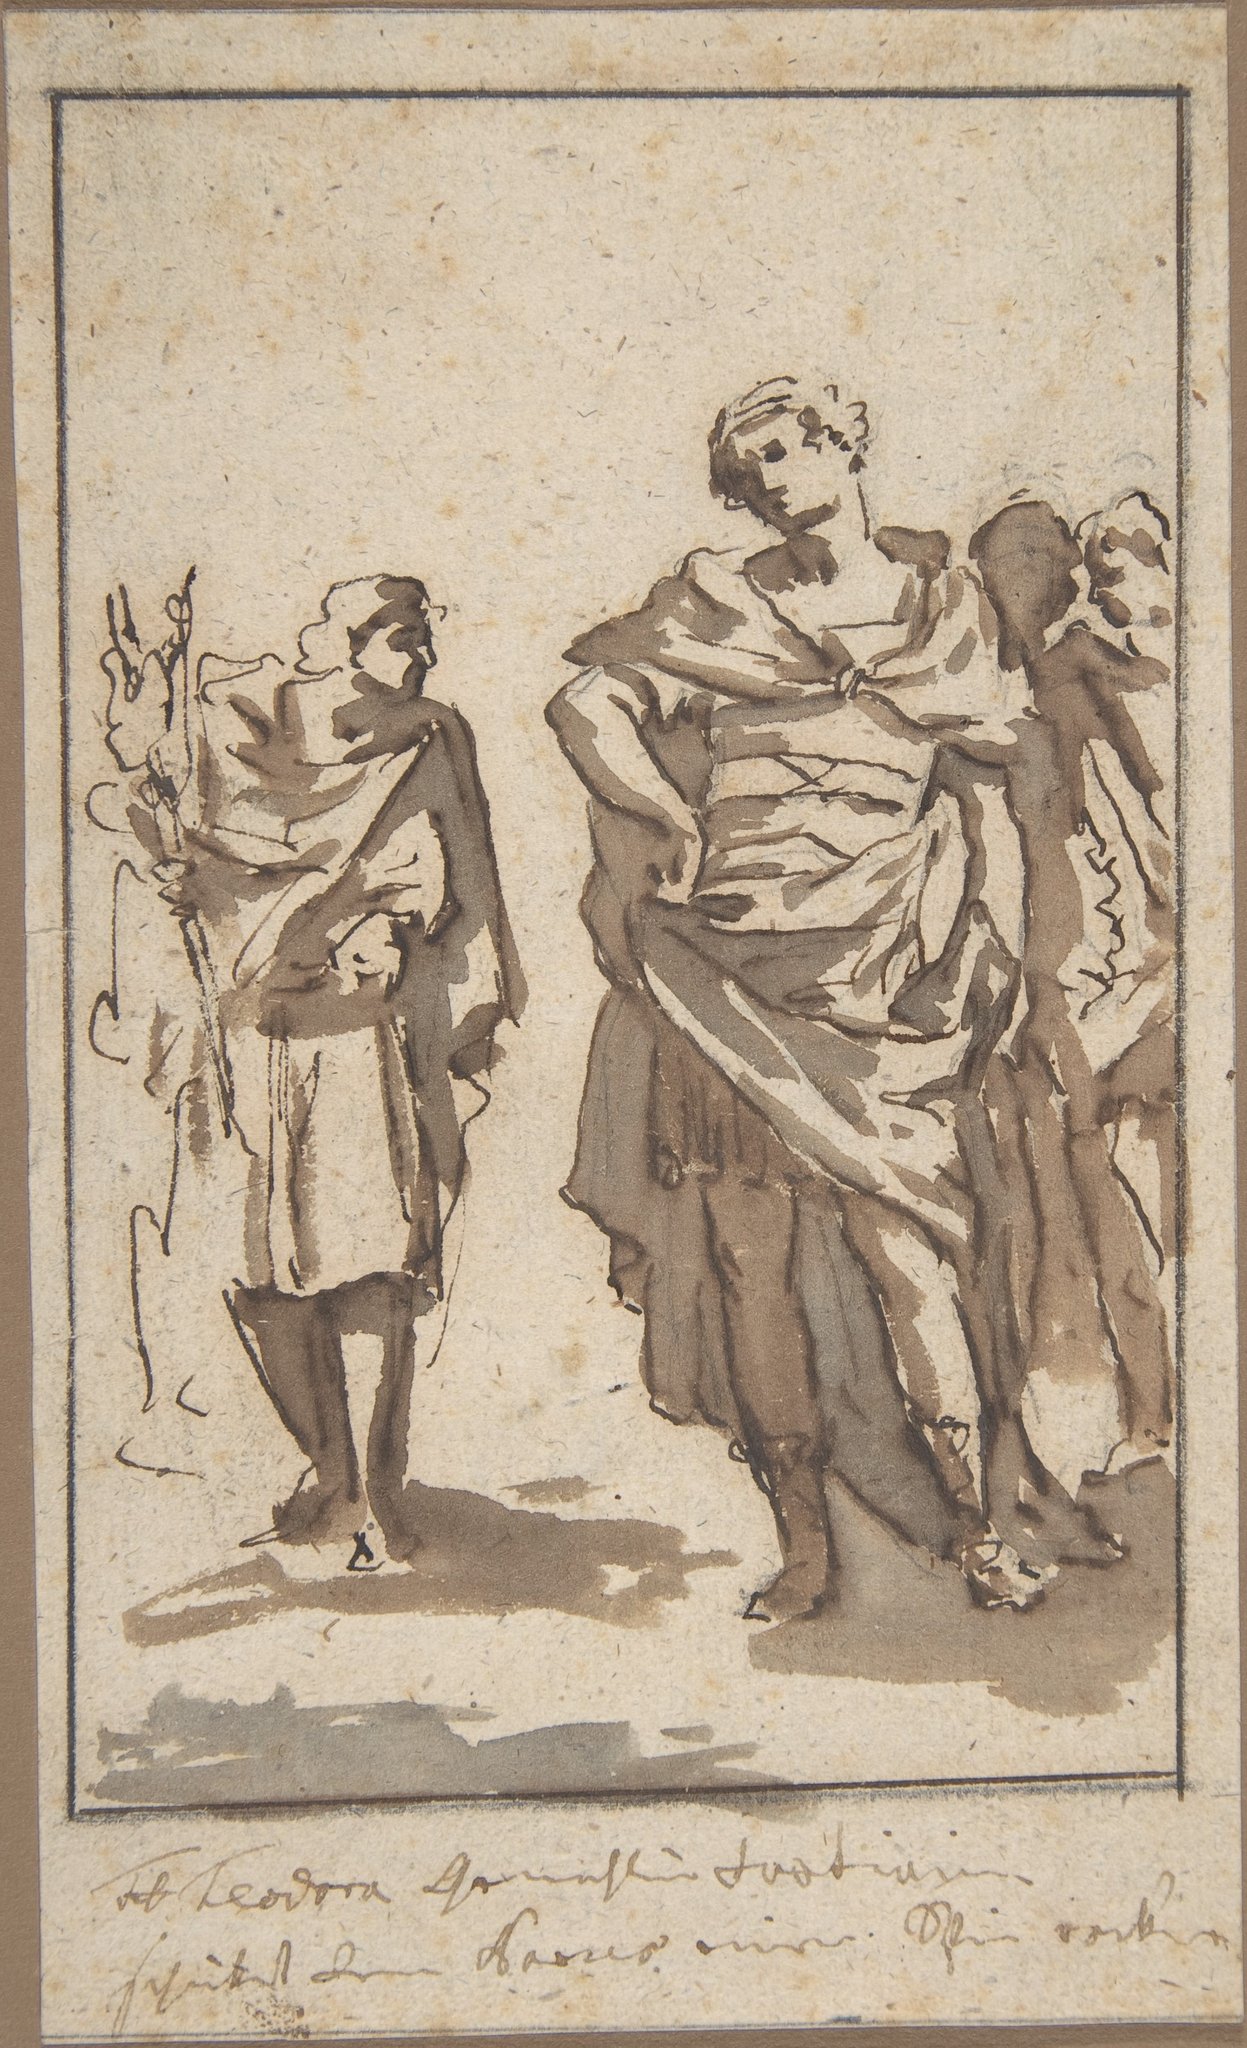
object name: drawing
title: Antique Subject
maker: anonymous, french, 17th century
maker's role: artist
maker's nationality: french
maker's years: 1600-1700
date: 1601-1700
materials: graphite, ink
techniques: brush, pen, wash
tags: men